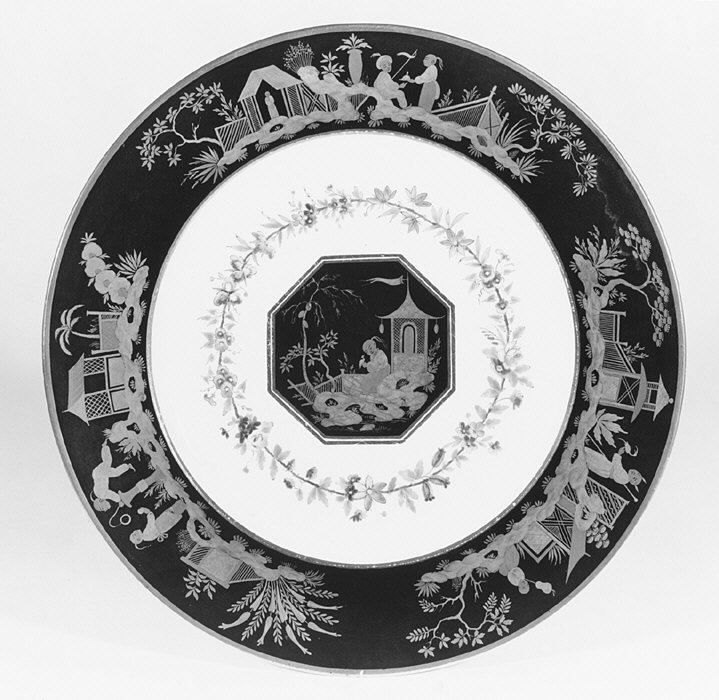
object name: plate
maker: sèvres manufactory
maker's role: manufactory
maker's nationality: french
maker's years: 1740-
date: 1791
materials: hard paste porcelain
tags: human figures,houses